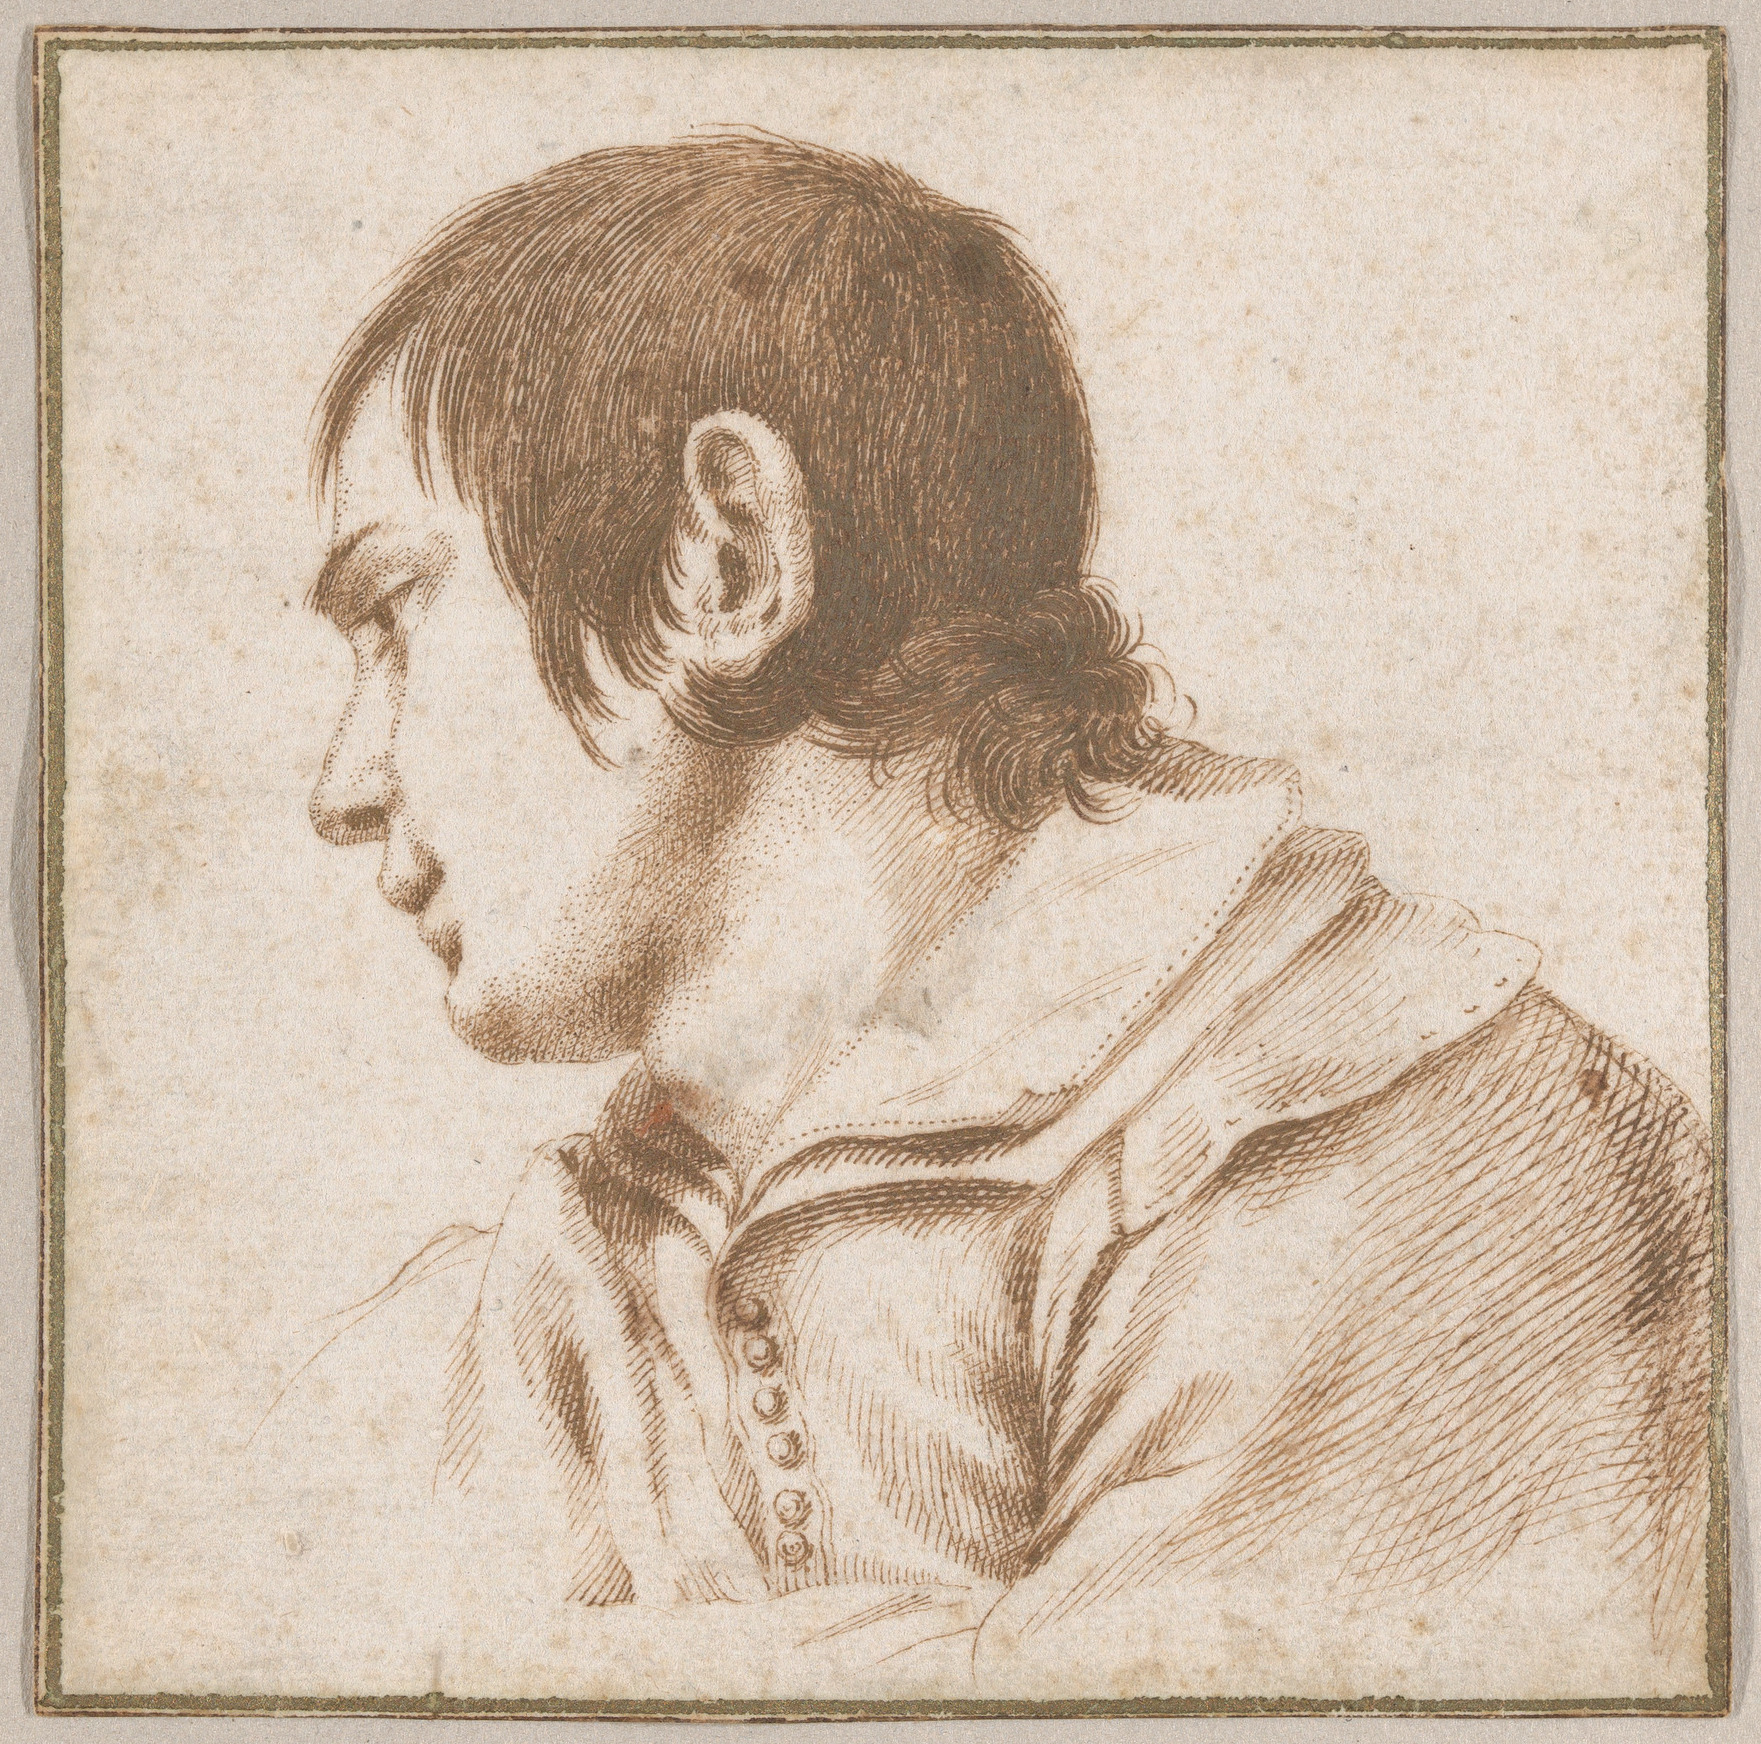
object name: drawing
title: Young Boy in Bust-Length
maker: guercino (giovanni francesco barbieri)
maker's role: artist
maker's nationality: italian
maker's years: 1591-1666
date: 1619-1630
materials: ink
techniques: pen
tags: boys,profiles